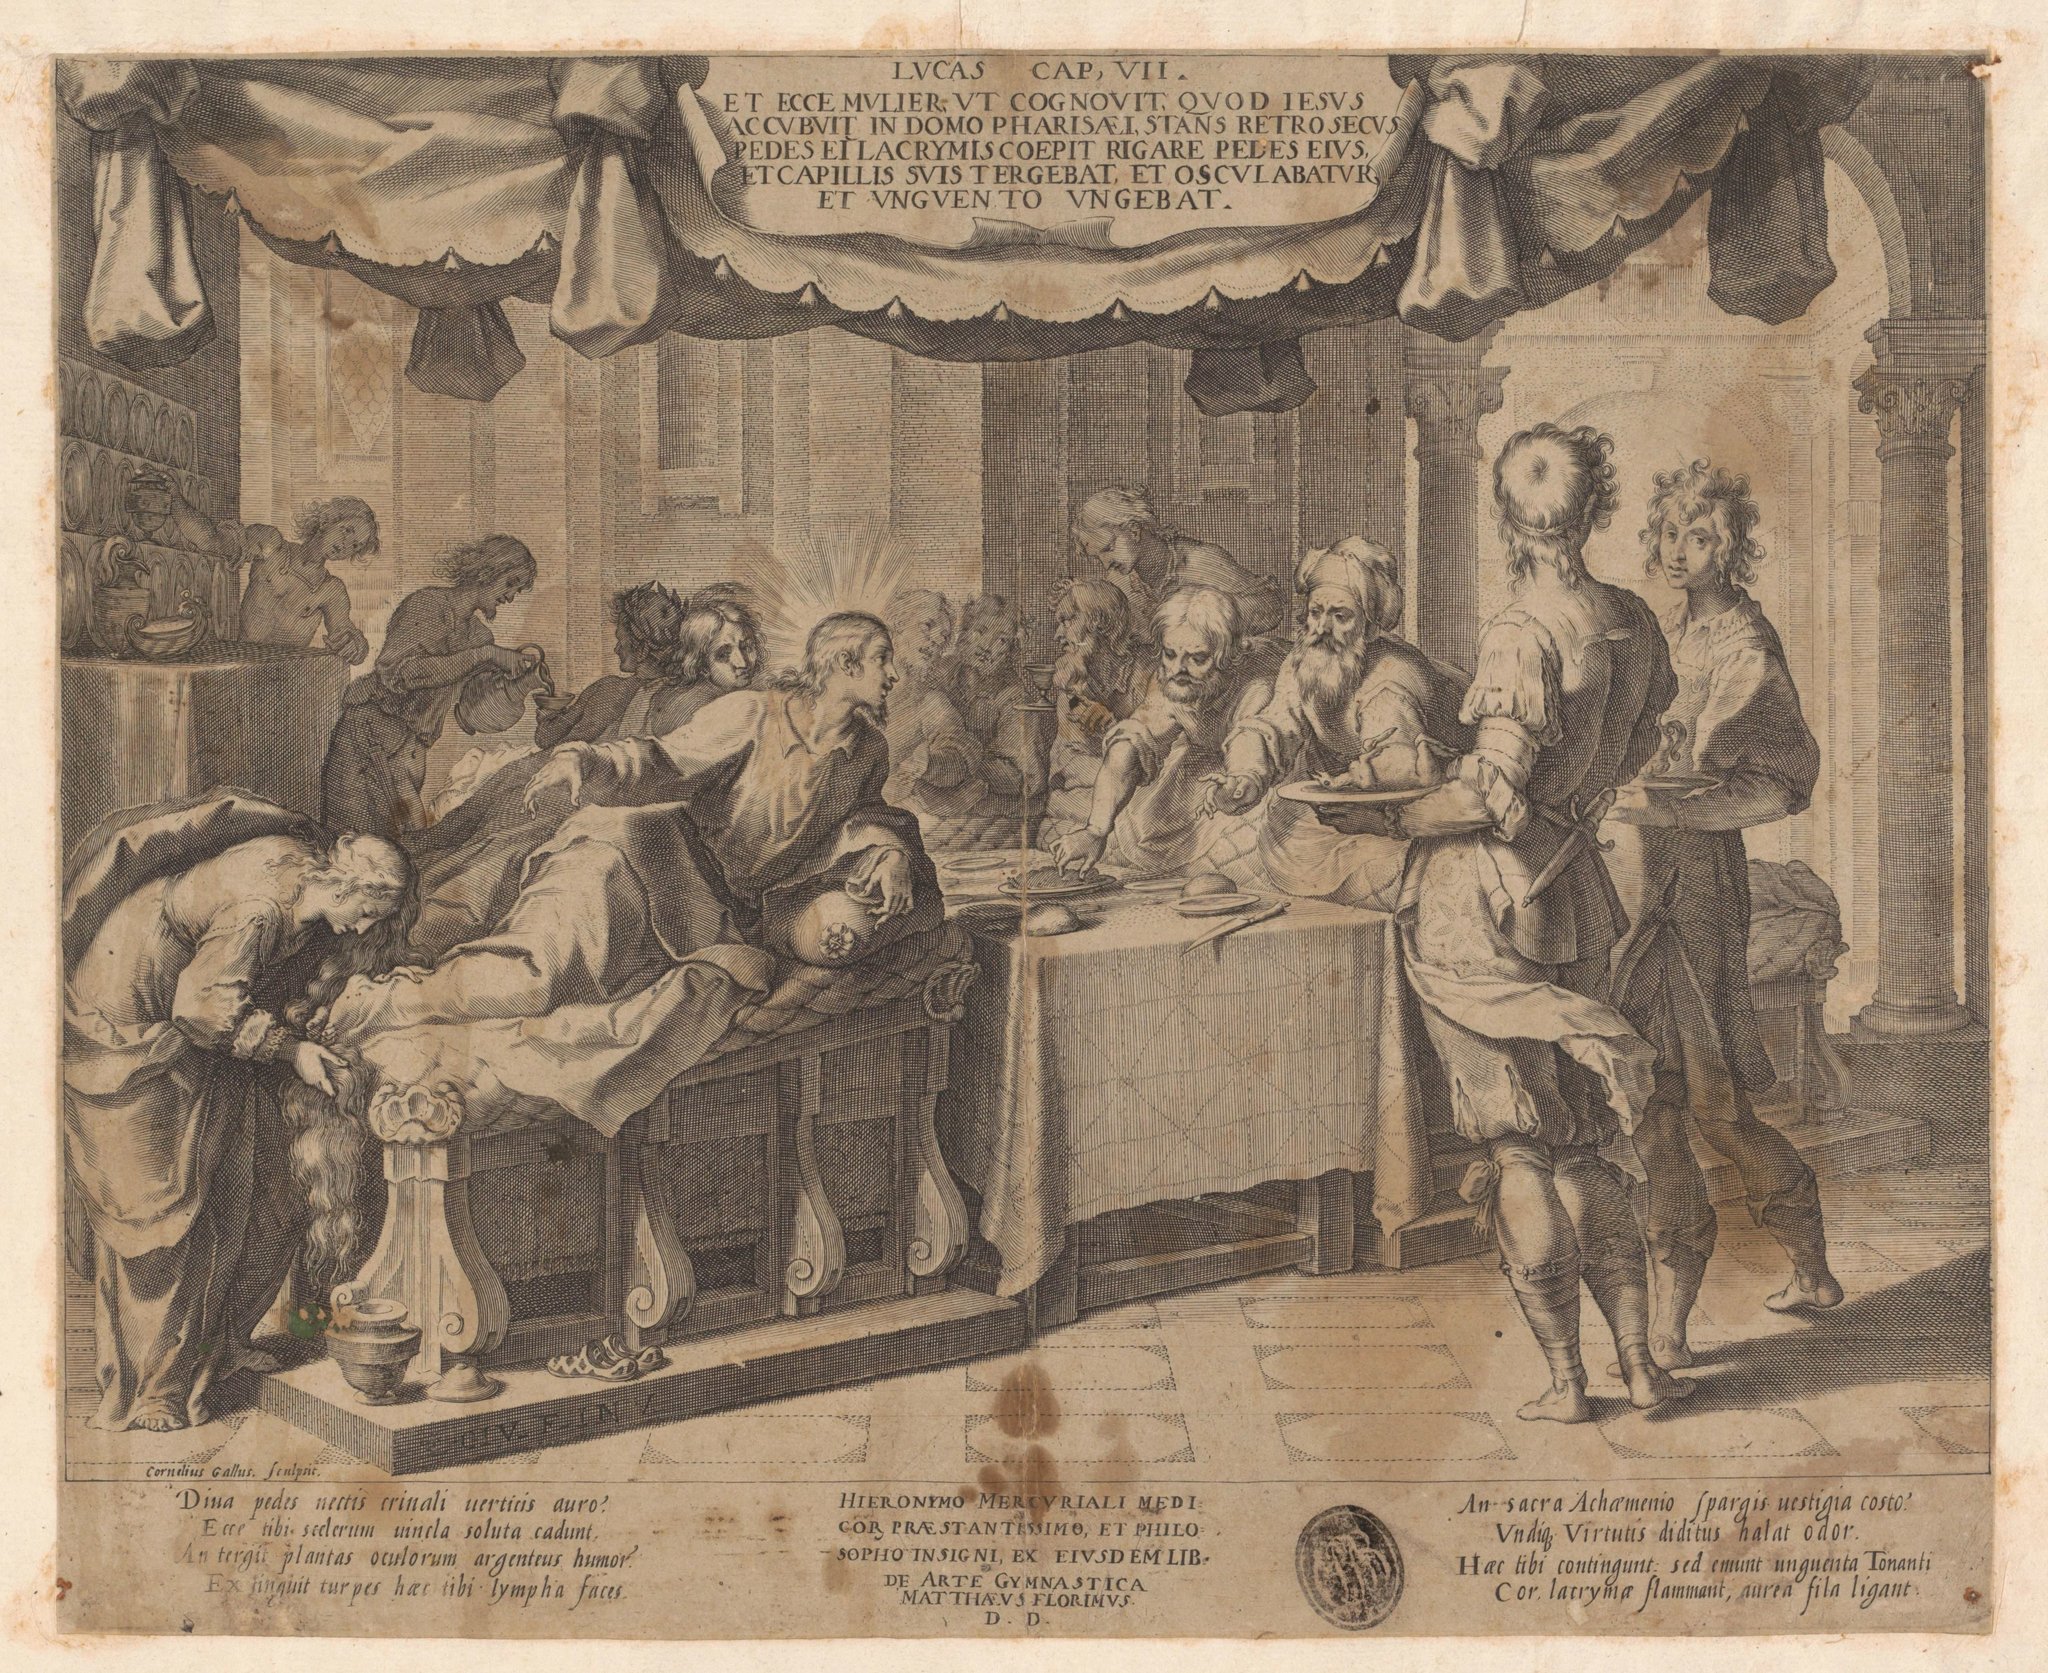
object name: print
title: Christus te gast bij Simon de Farizeeër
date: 1590-1610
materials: paper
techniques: engraving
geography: italy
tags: a woman washes christ's feet with her tears, and wipes them with her hair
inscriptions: collector's mark: Lugt 2228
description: Christus is te gast in het huis van Simon de Farizeeër. Hij ligt aan tafel terwijl Maria Magdalena zijn voeten zalft en met haar haar droogt. Twee bedienden staan voor de tafel en brengen schalen met gebraden gevogelte. Onder de voorstelling een vers in het Latijn.